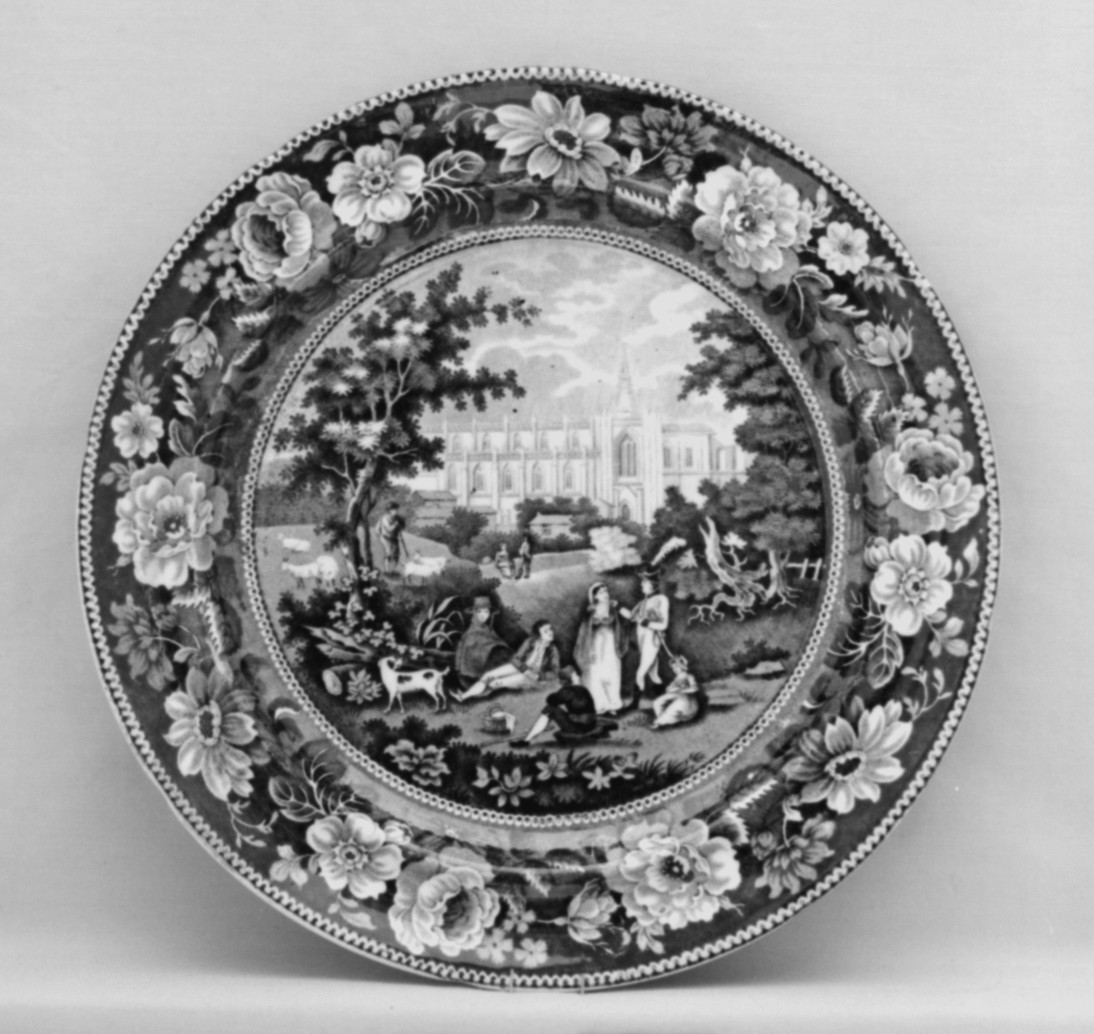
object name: plate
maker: a. stevenson, cobridge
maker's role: maker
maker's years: 1820-1840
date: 1801-1900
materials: pottery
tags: buildings,men,women,trees